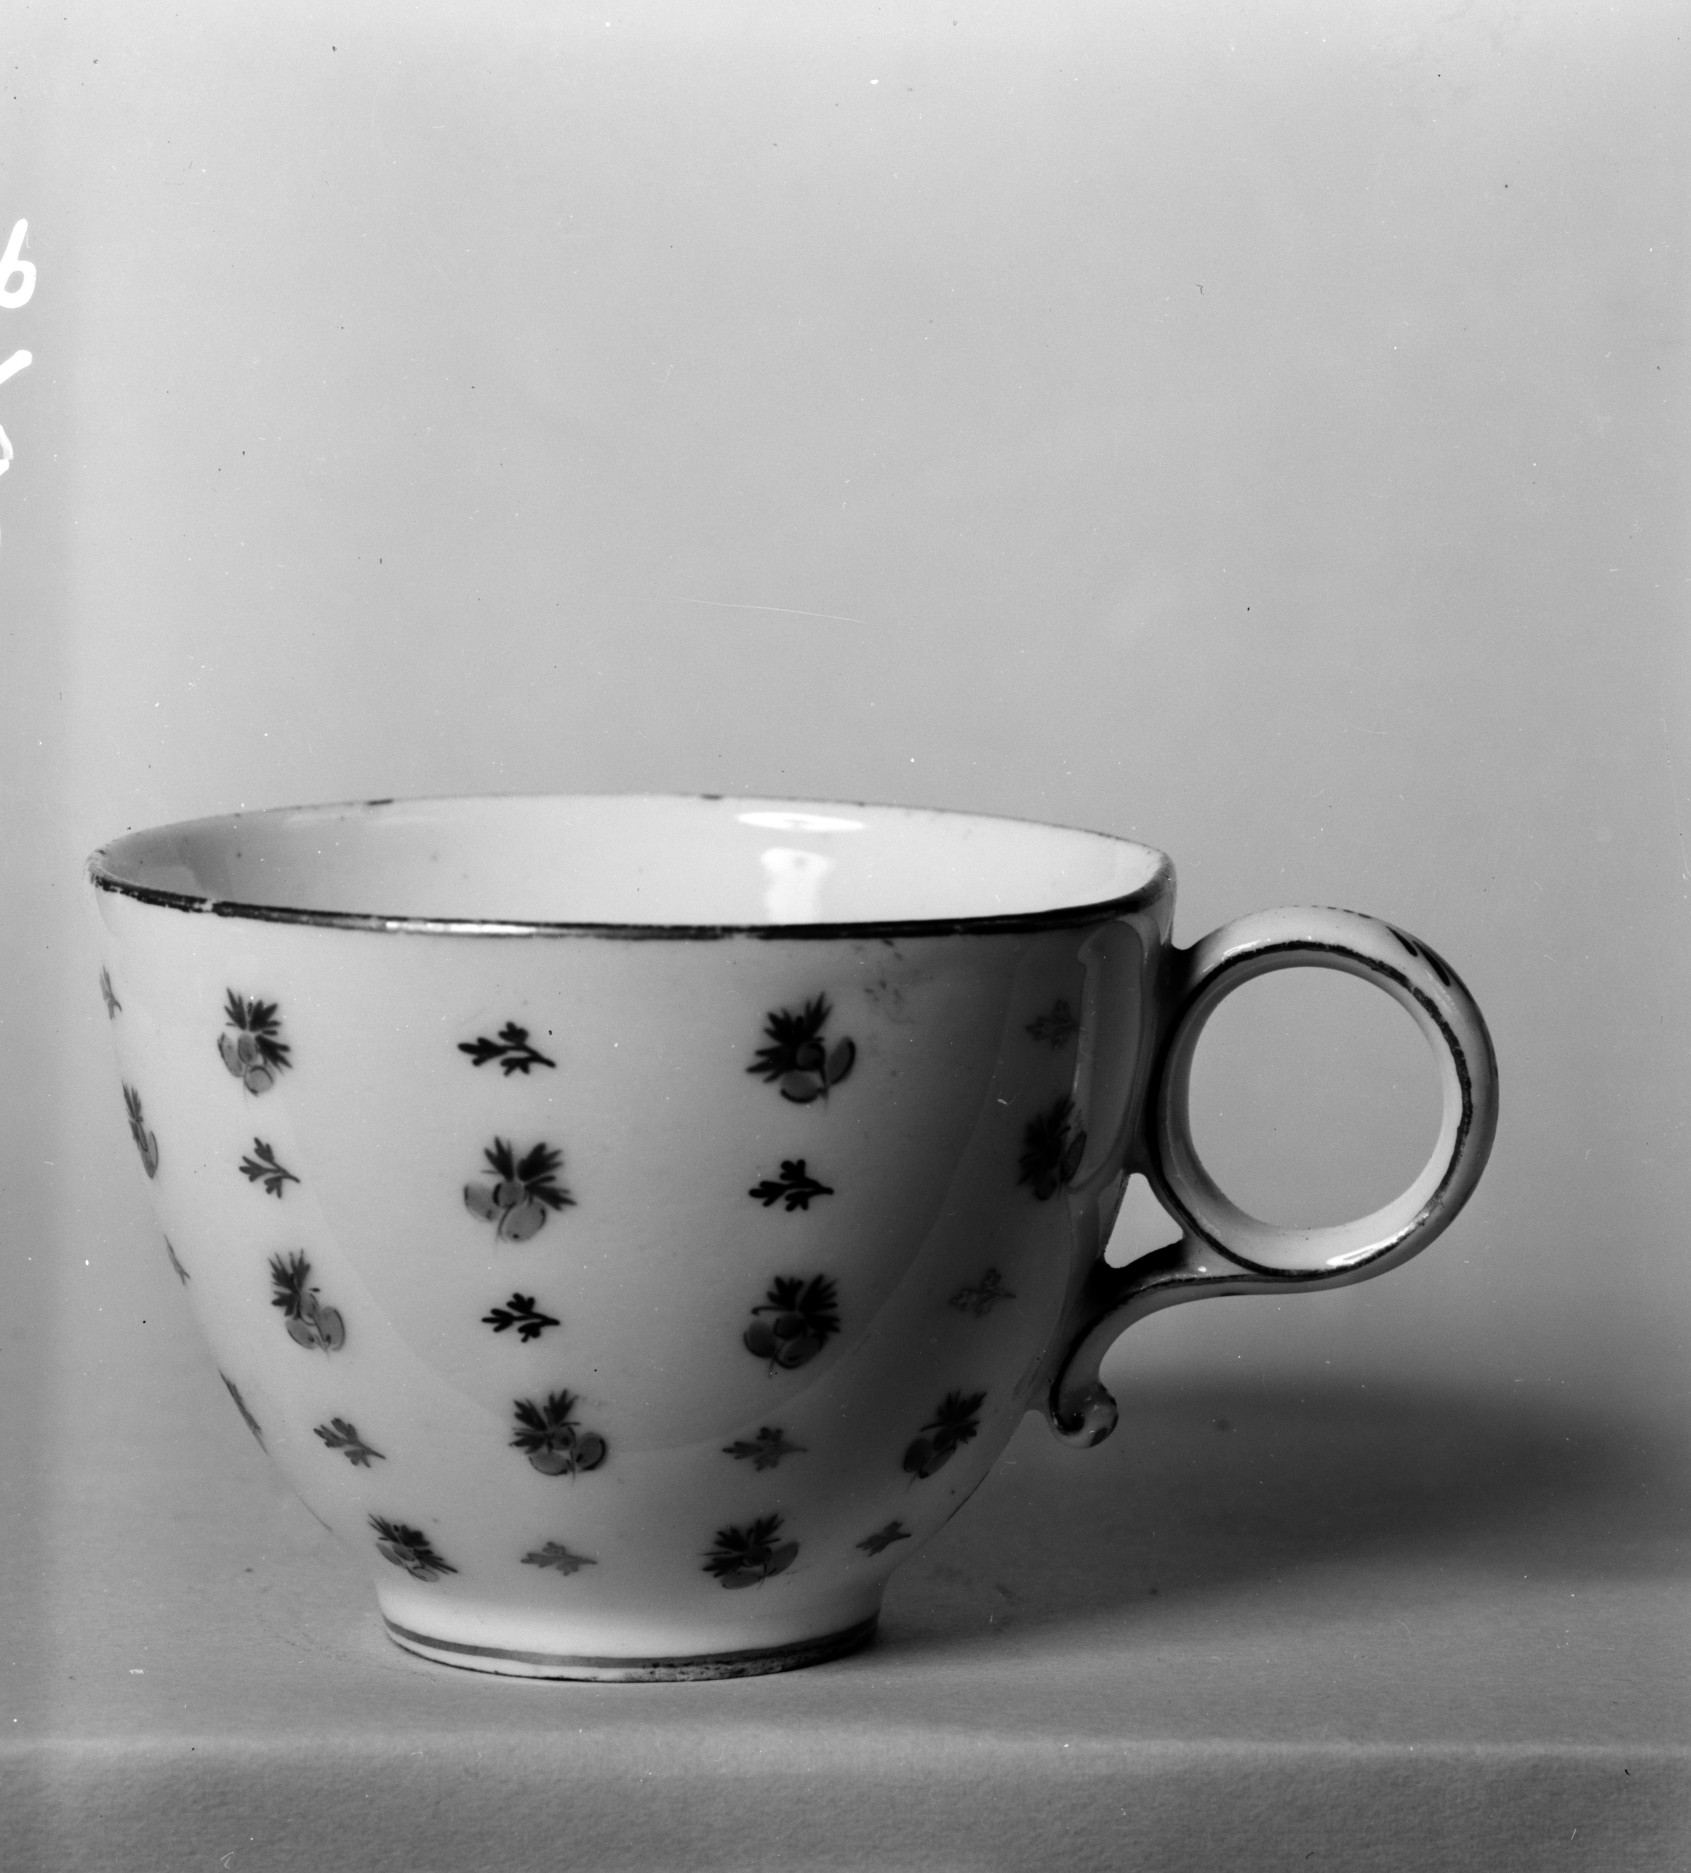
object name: cup and saucer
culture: french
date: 1780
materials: porcelain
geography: france